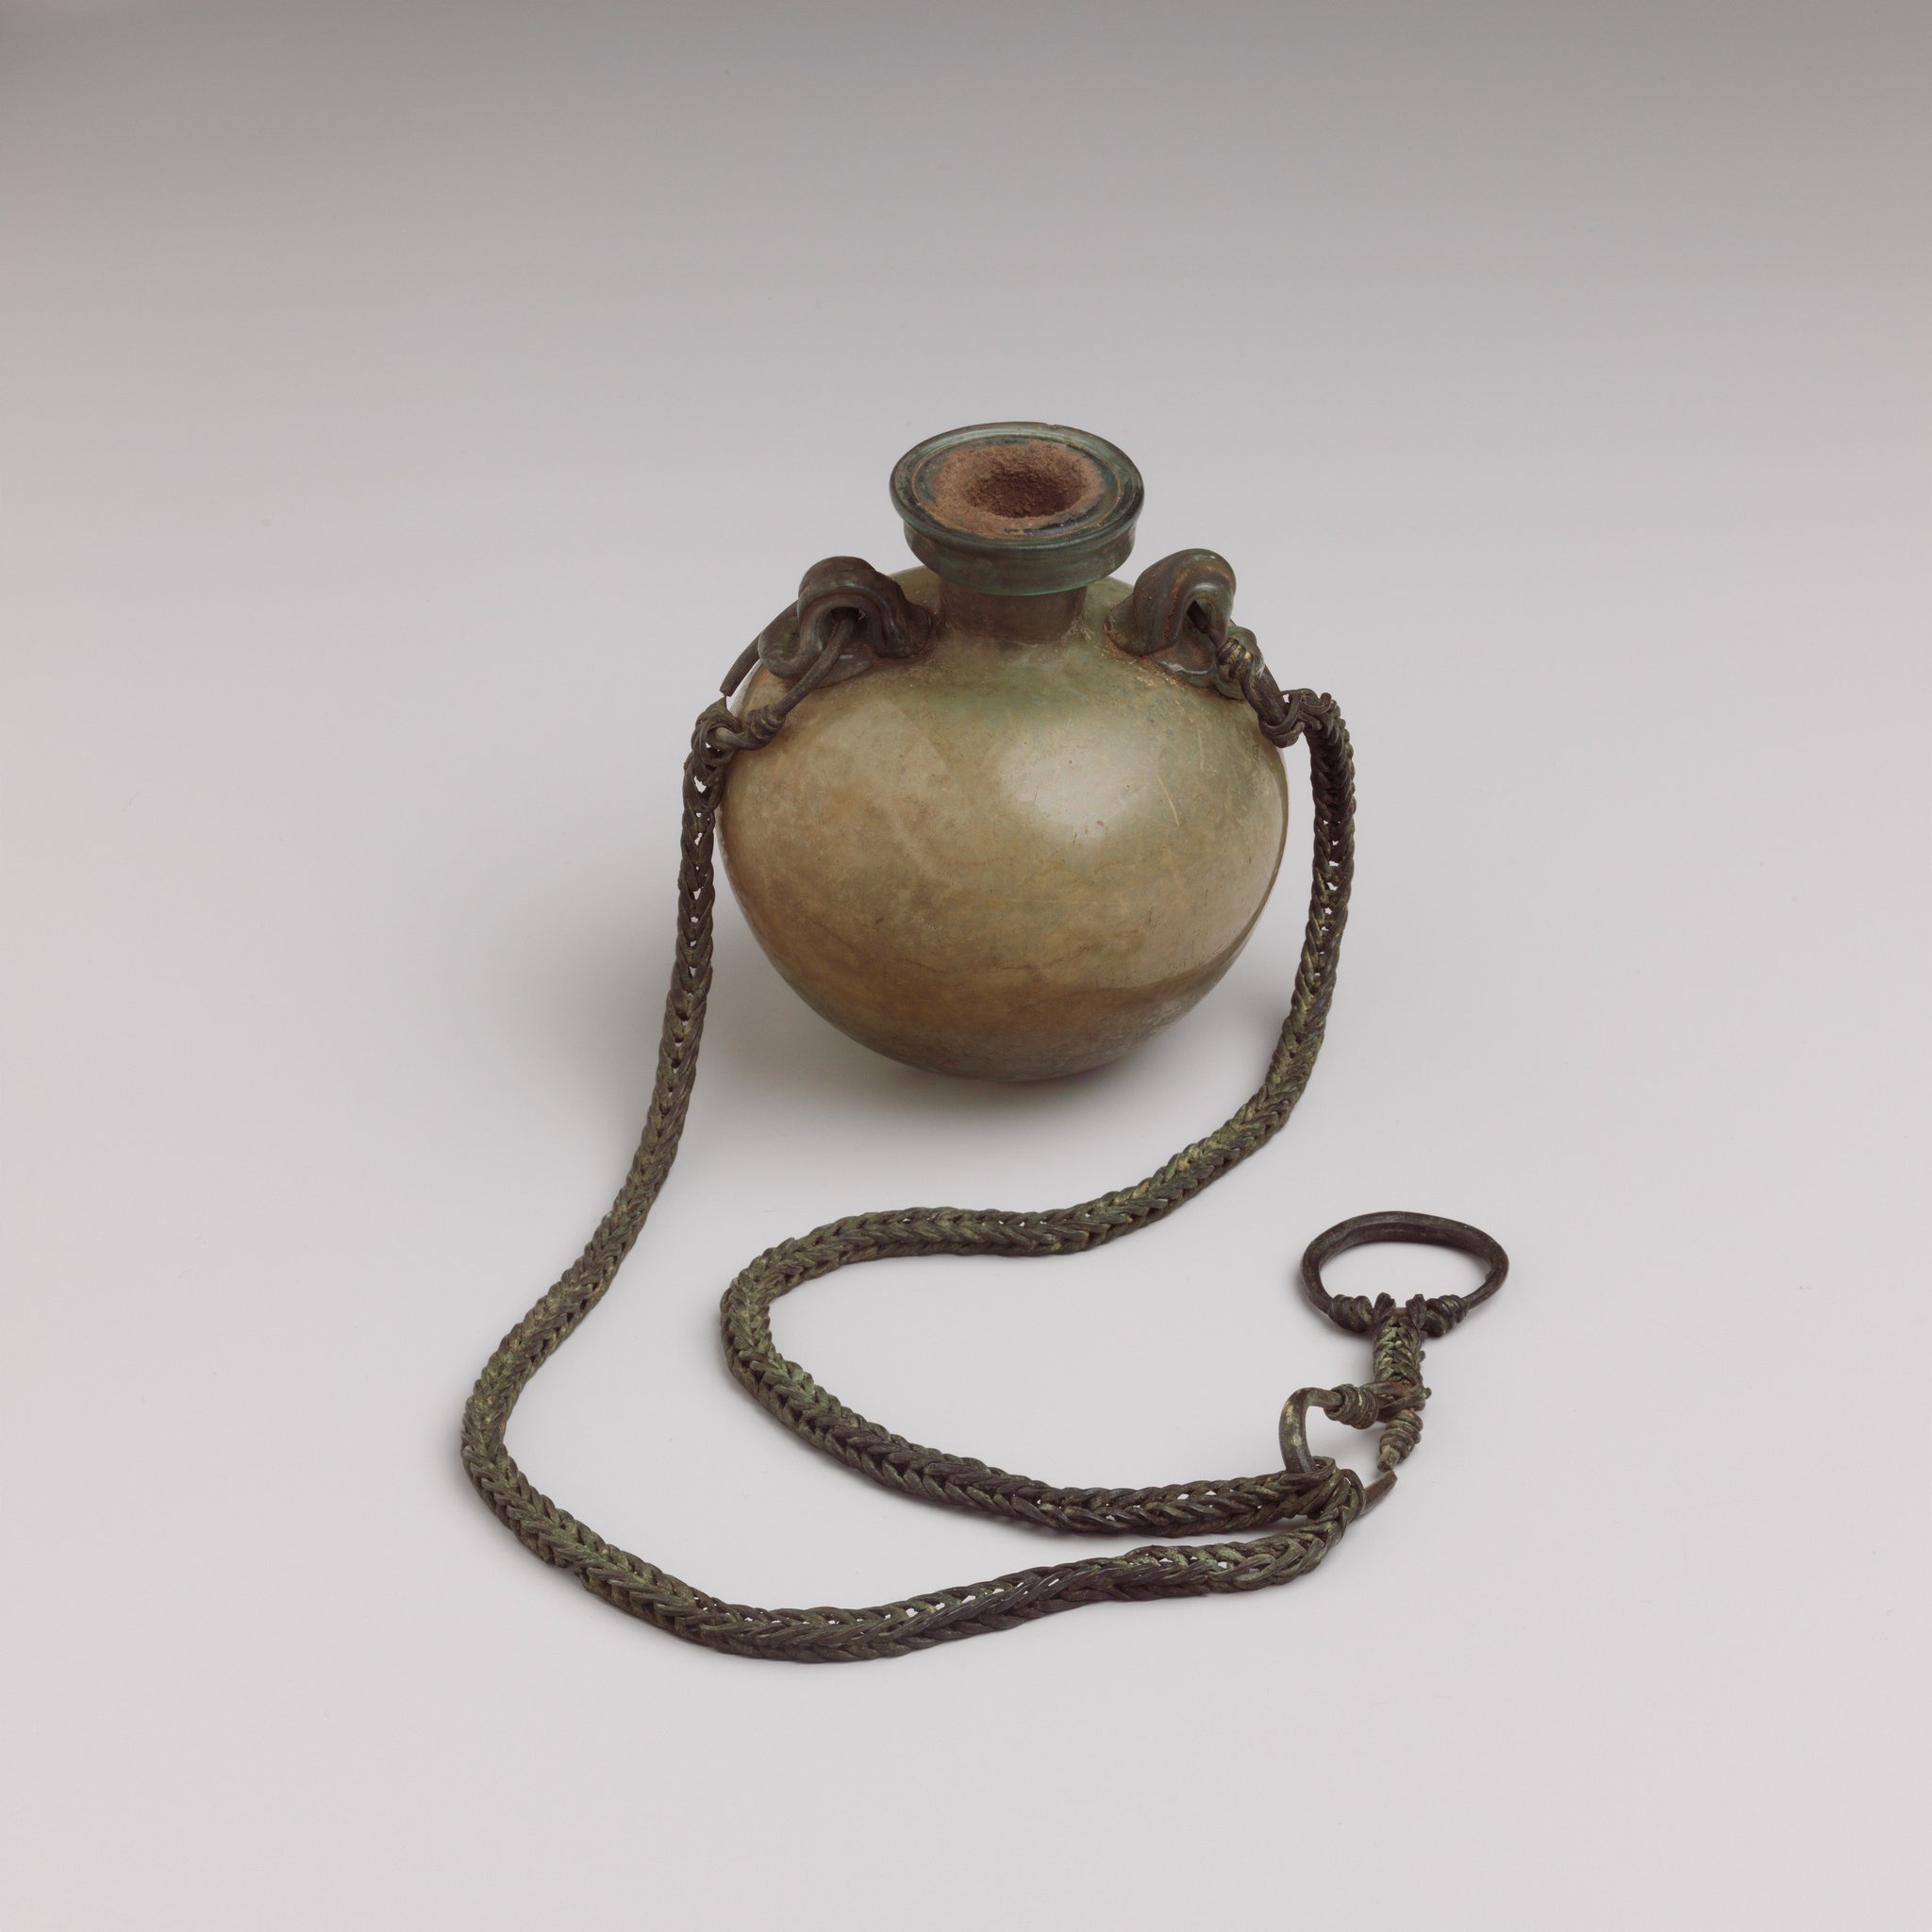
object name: aryballos with bronze ring handle and chain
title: Glass aryballus (oil bottle) with bronze suspension chain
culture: roman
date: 1-200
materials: bronze, glass